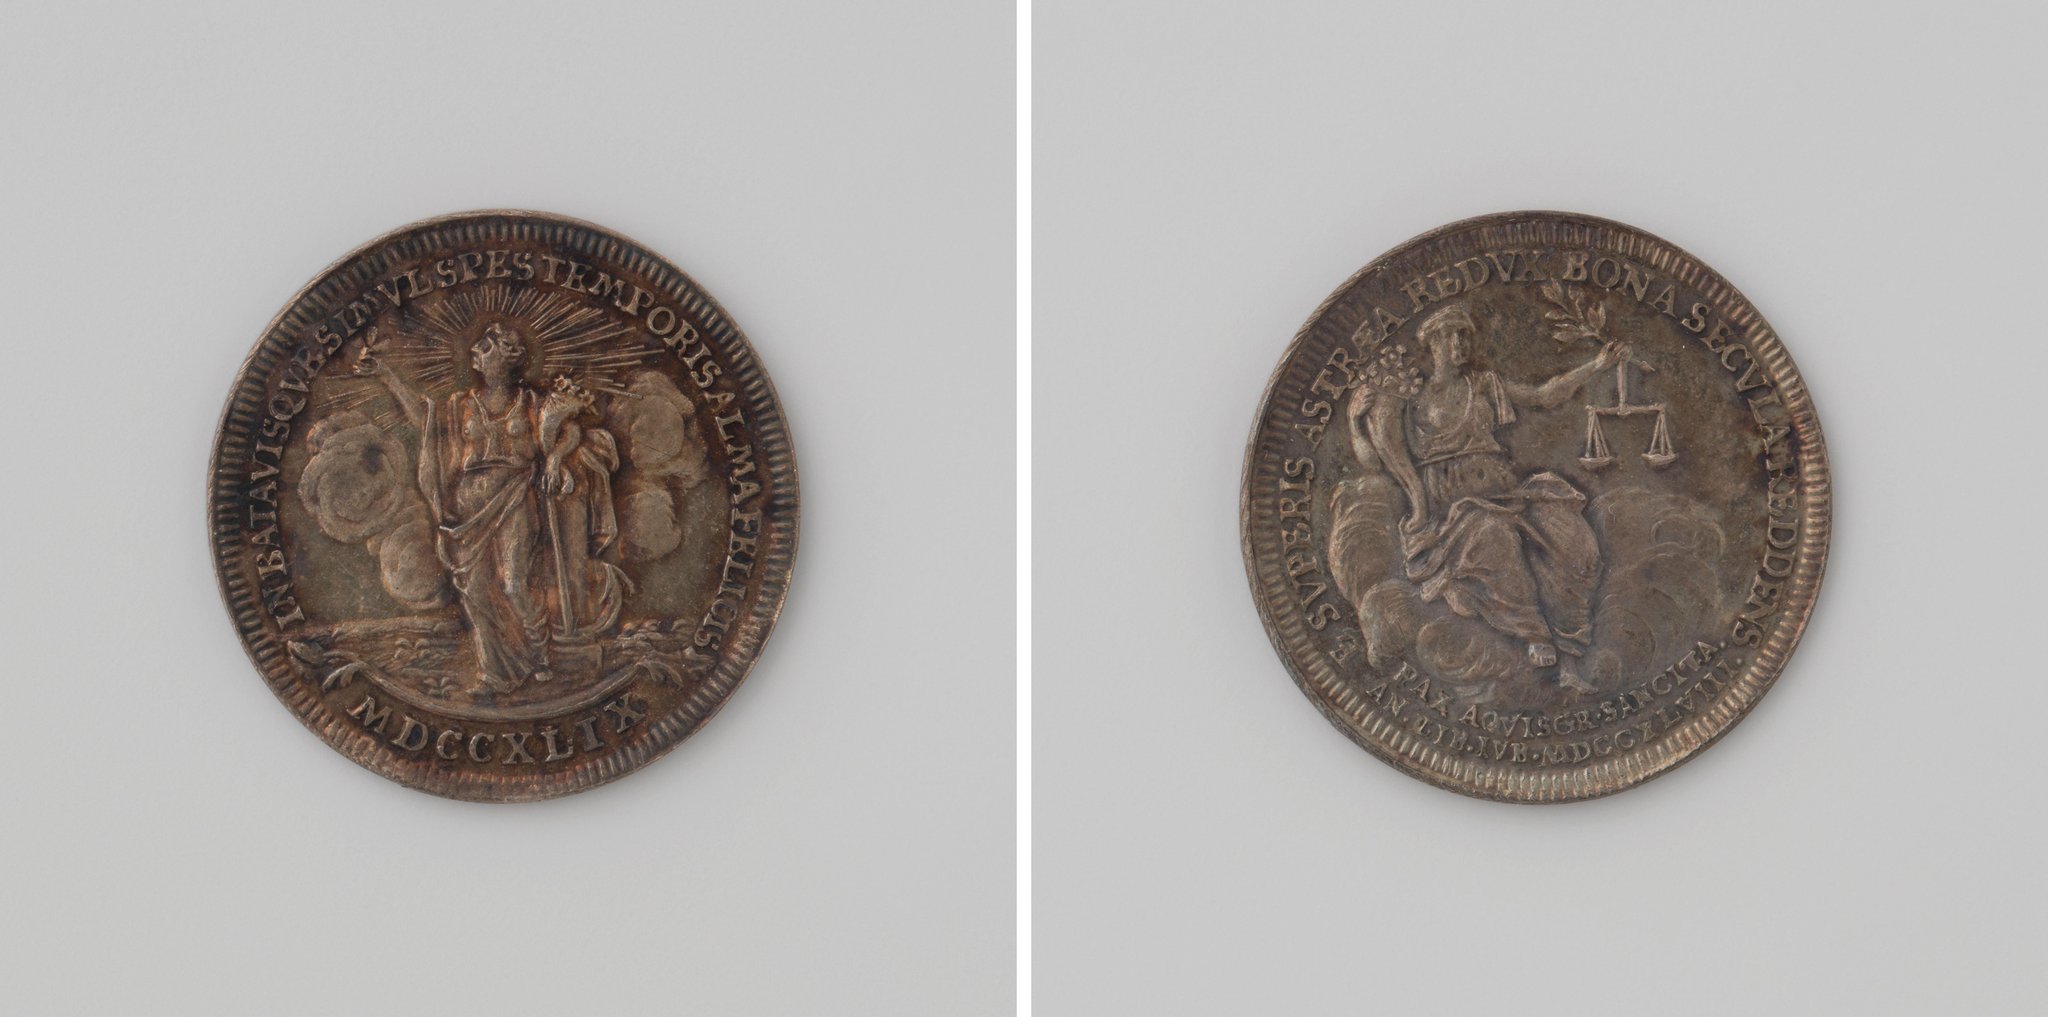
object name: new year medal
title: Aanvang van het jaar 1749 en vrede te Aken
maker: martinus holtzhey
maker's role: medailleur, muntmaker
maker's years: 1697-1764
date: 1748-1749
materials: silver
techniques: striking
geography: amsterdam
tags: aken, vrede van aken (1748), nieuwjaar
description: Zilveren penning. Voorzijde: Vrede, afgebeeld als vrouw met stralenkrans, houdt bloem, hoorn van overvloed en anker in handen boven jaartal in lijst, binnen omschrift. Keerzijde: Astrea met hoorn van overvloed, olijftak en weegschaal in handen, daalt neer op een wolk binnen tweeregelig omschrift